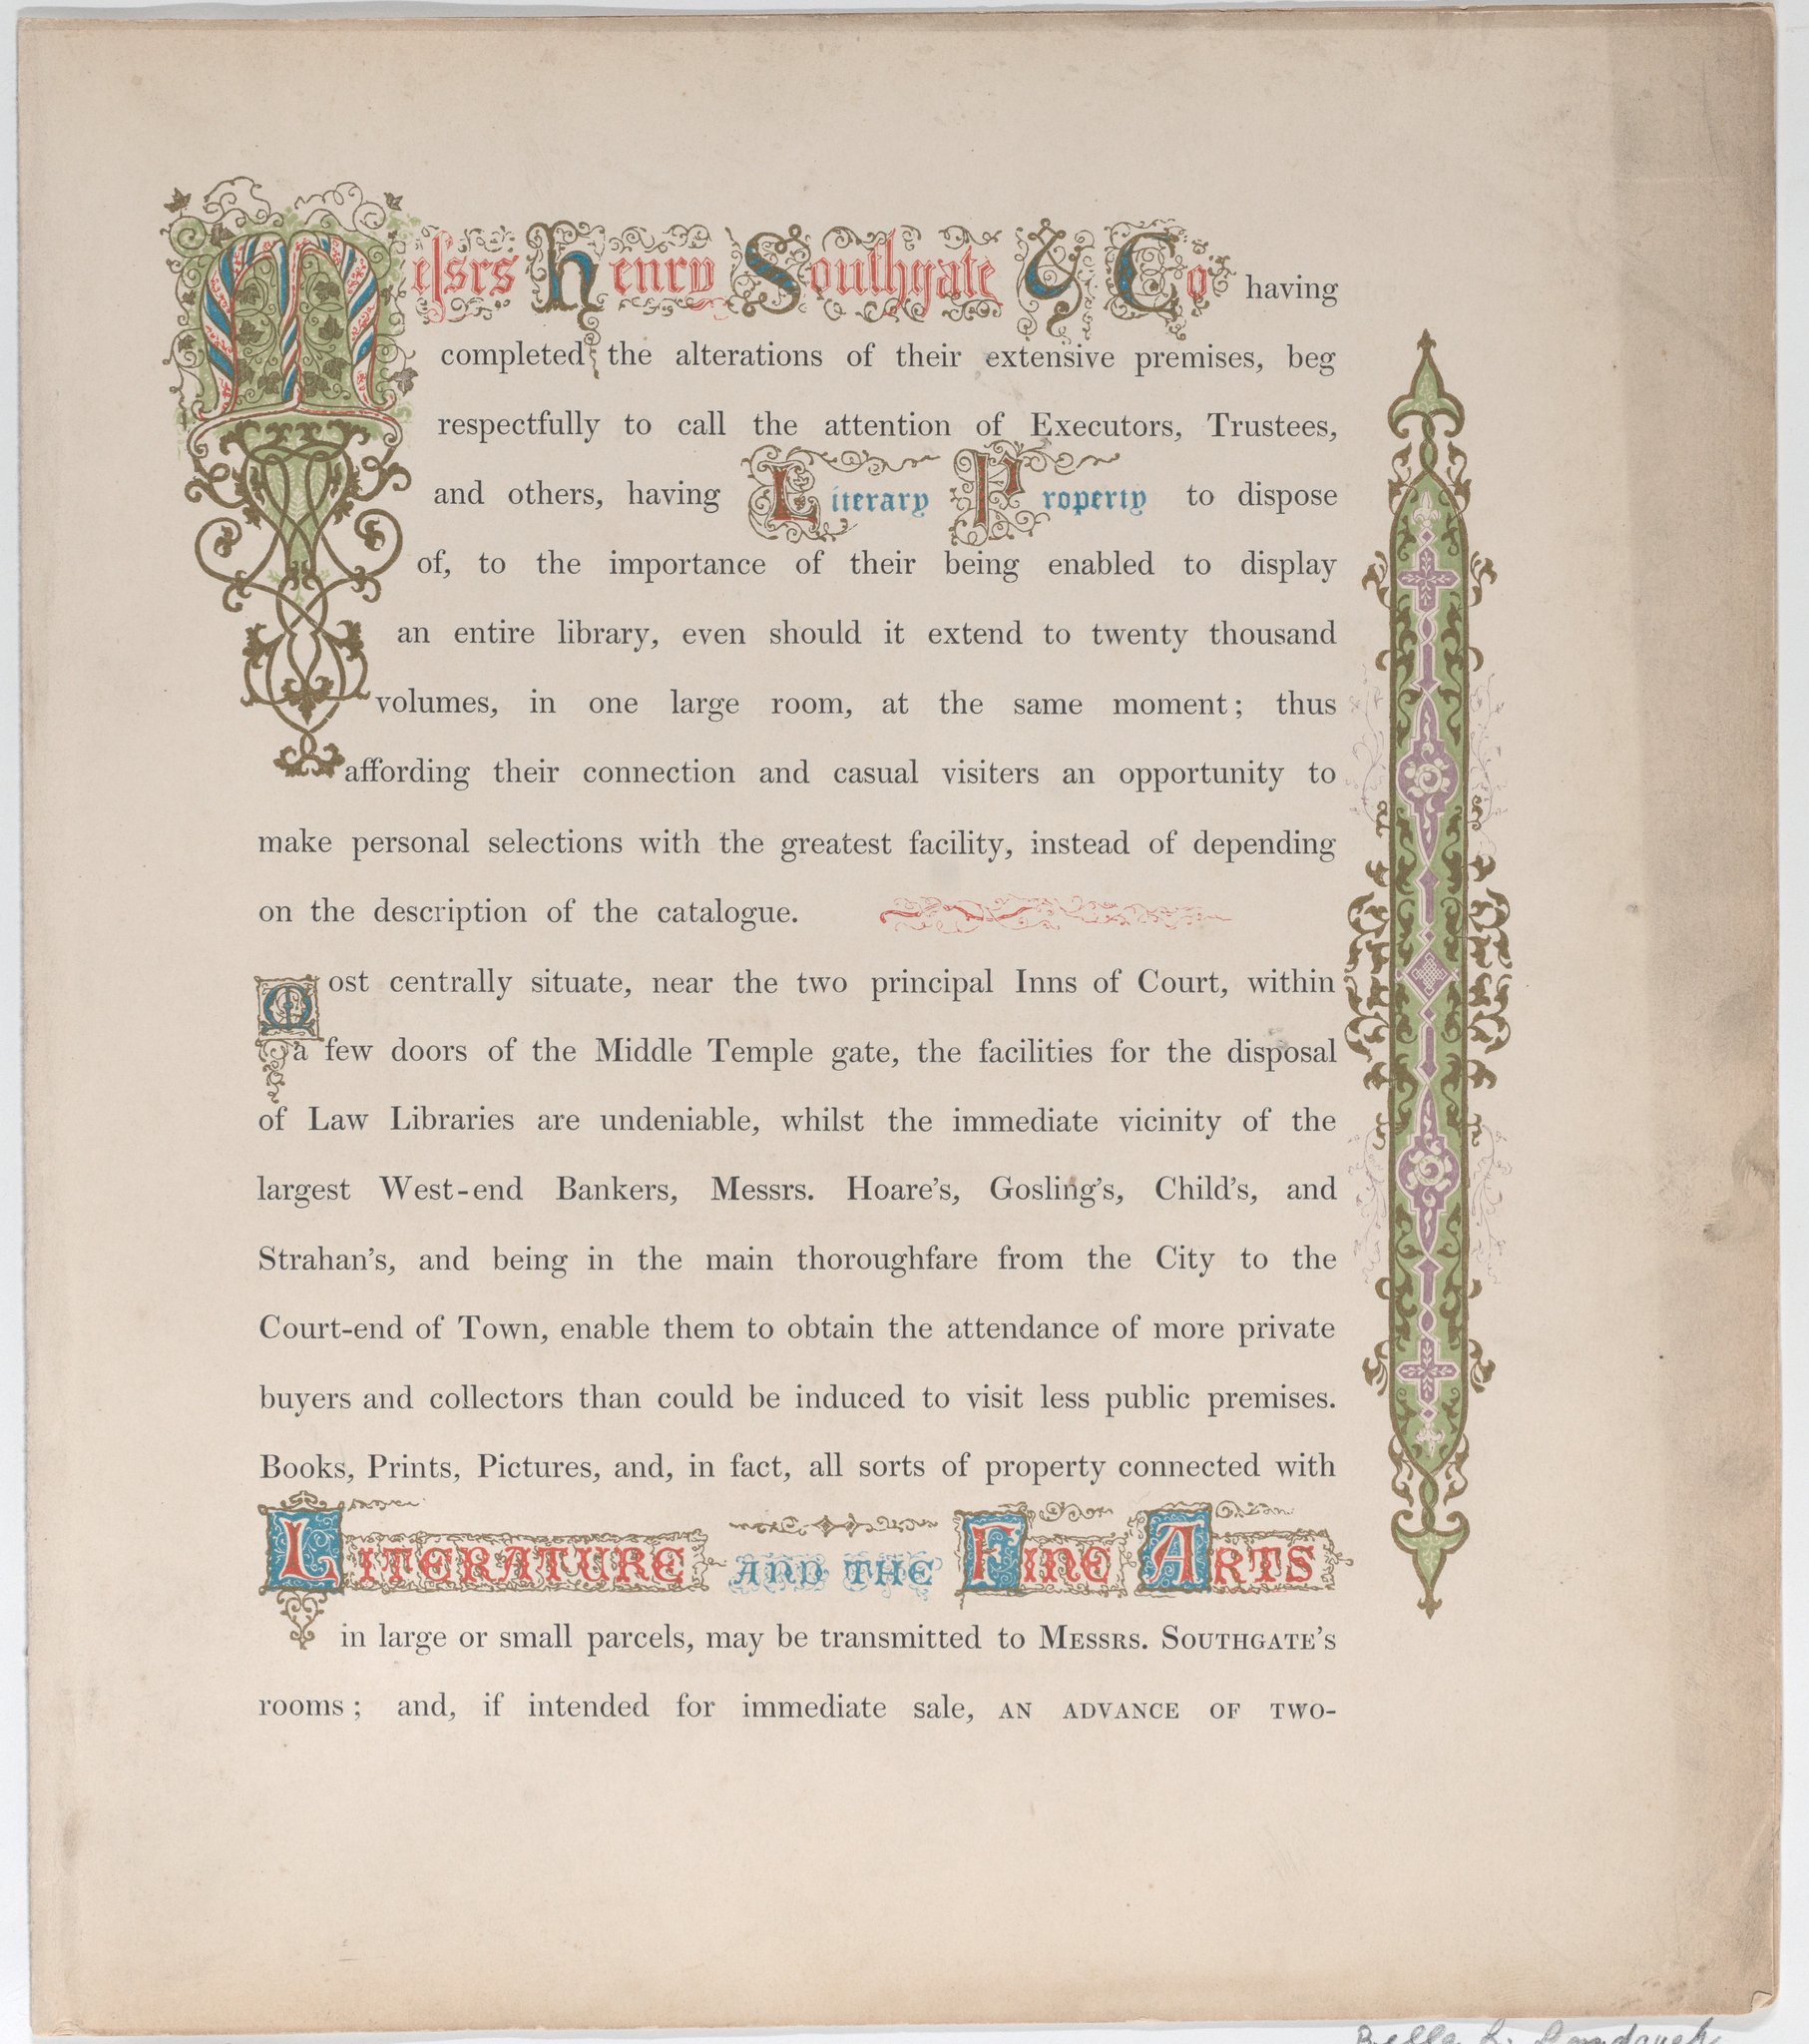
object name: print, trade card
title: Trade Card for Messrs. Henry Southgate & Co., Book Sellers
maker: vizetelly brothers & co.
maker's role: artist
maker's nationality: british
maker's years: 1800-1899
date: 1801-1900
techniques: lithography